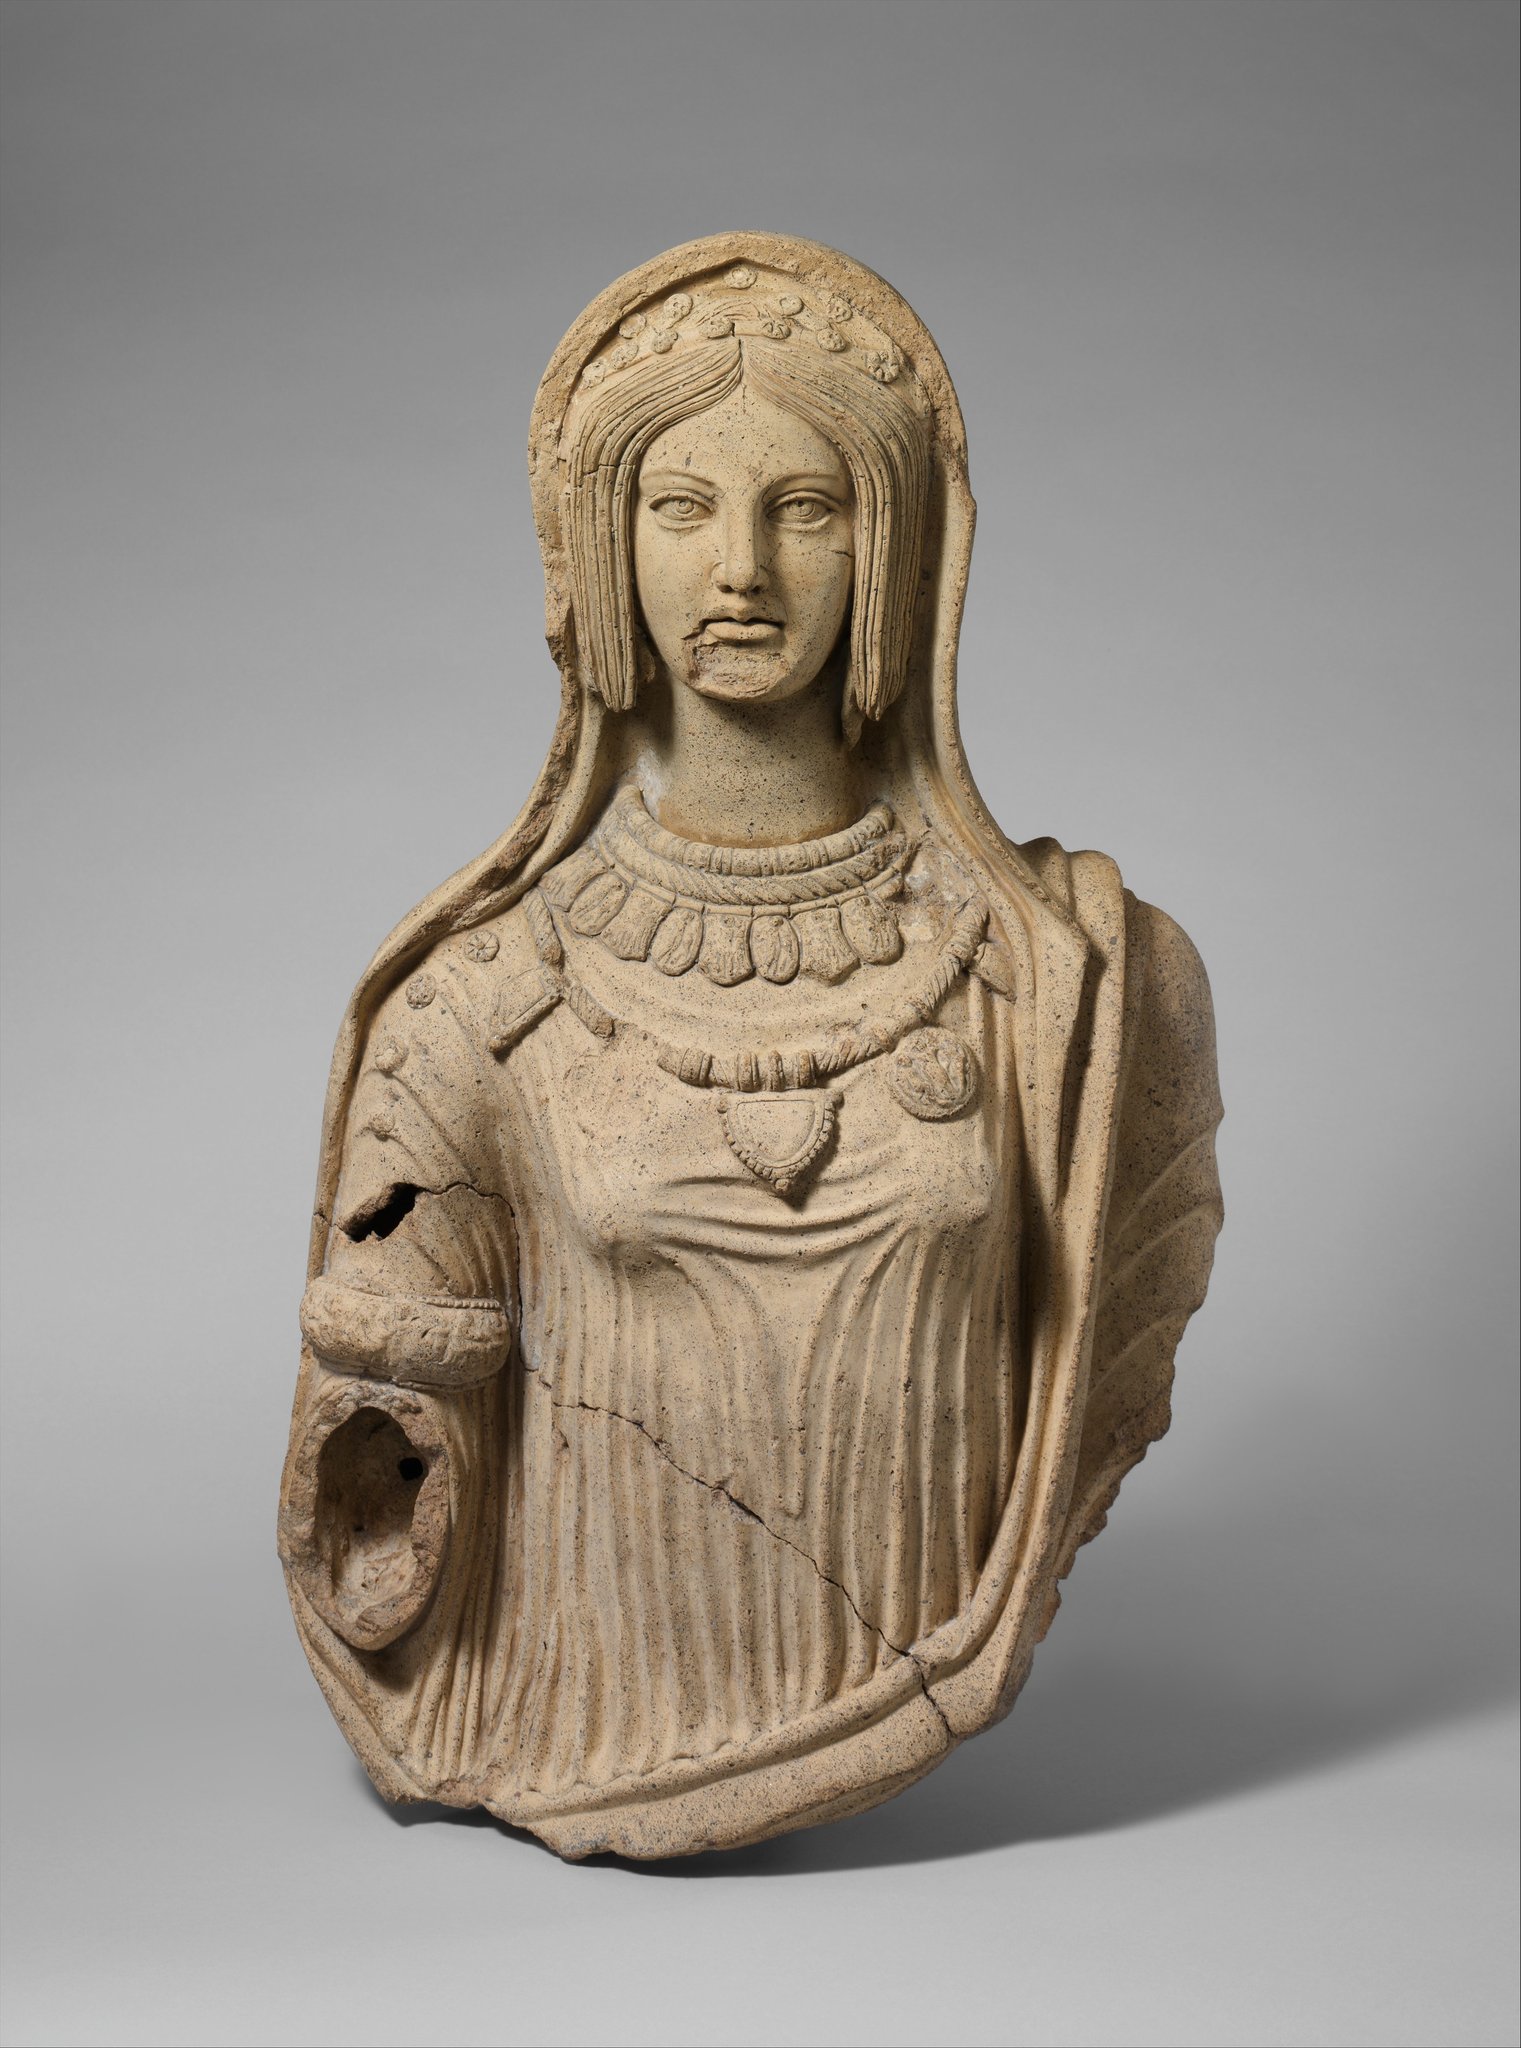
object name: statue of a woman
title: Terracotta statue of a young woman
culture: etruscan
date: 334-268 BCE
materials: terracotta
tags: necklaces,women